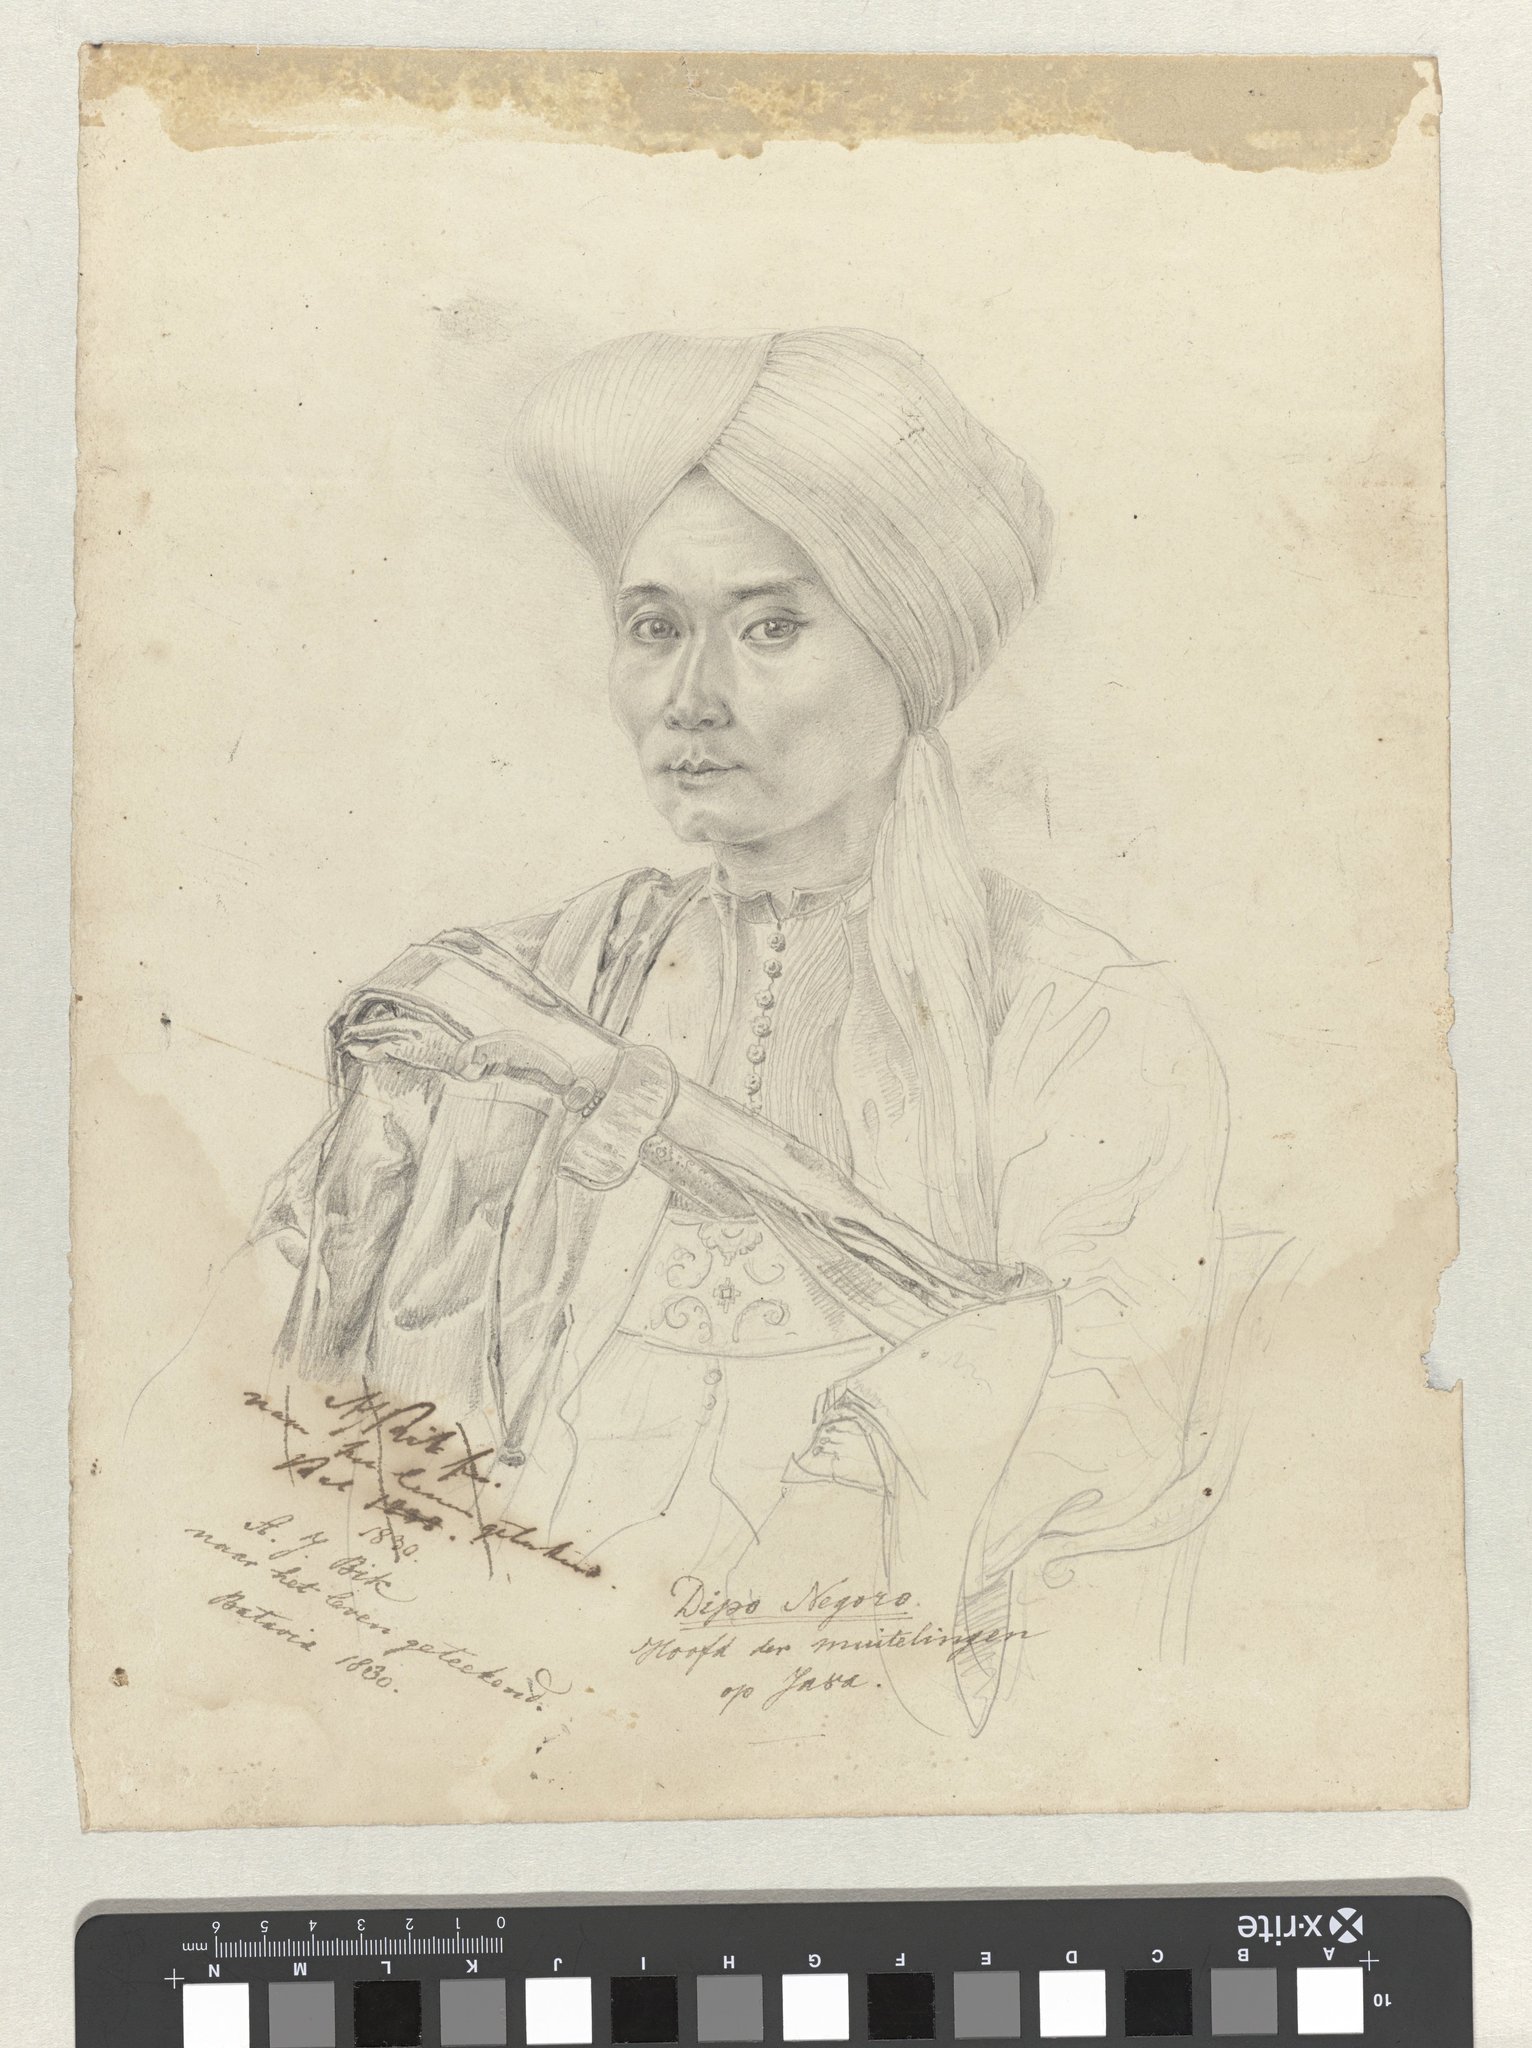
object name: drawing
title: Diponegoro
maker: adrianus johannes bik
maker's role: draughtsman, print maker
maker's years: 1790-1872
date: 1830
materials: paper, pencil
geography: batavia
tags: diponegoro, java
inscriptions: inscription: ‘Dipo Negoro/ Hoofd der muitelingen /op Java.’, signature: ‘A.J. Bik/ naar het leven geteekend./ Batavia 1830.’